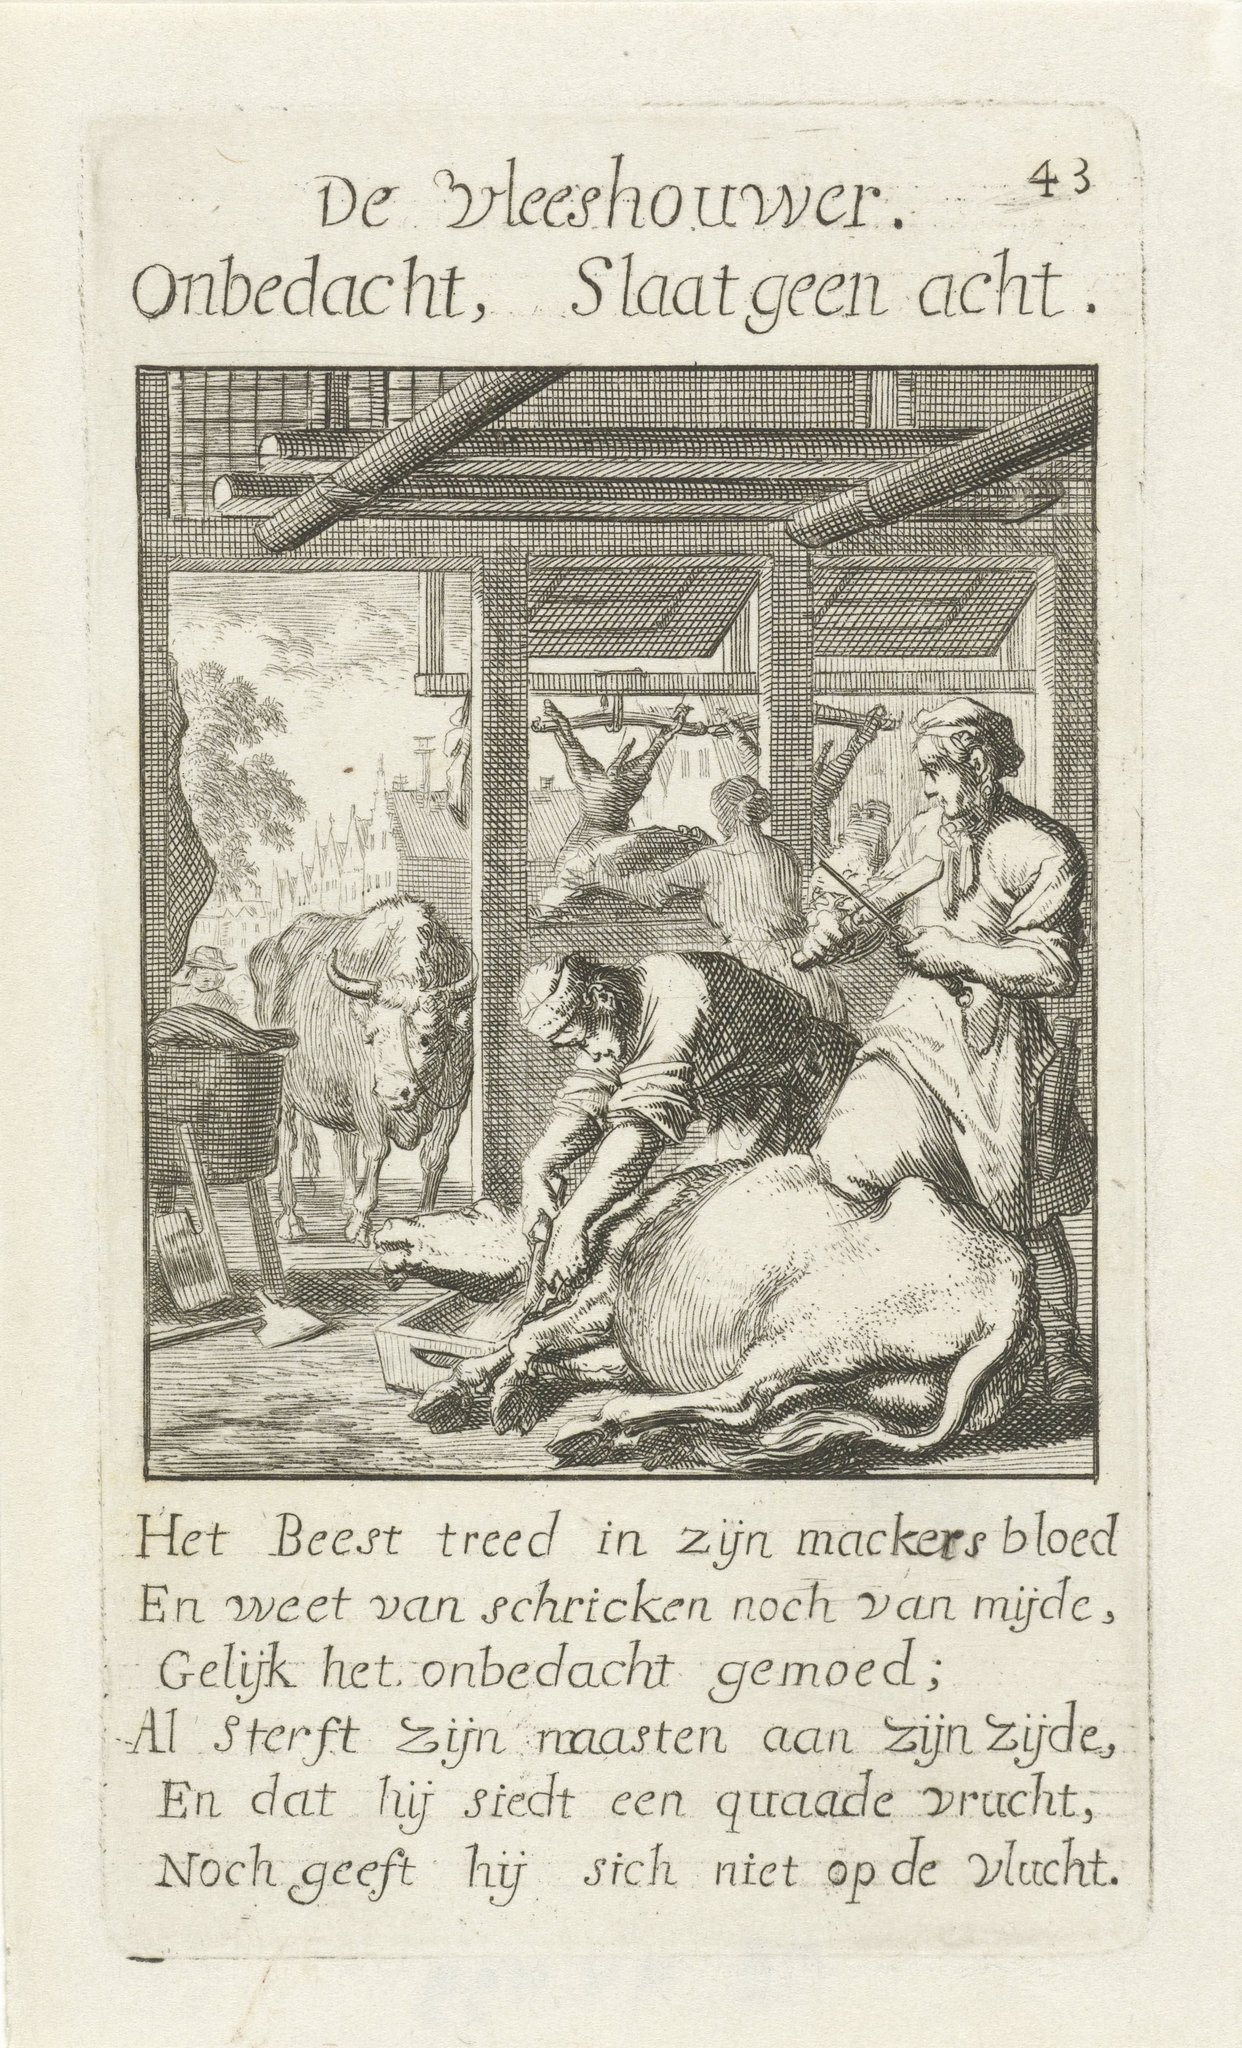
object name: print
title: Het Menselyk Bedryf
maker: jan luyken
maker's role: draughtsman, print maker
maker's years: 1649-1712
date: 1694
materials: paper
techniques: etching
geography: amsterdam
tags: handicrafts, craftsman at work, butcher, slaughterman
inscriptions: collector's mark: Lugt 2228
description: Maakt deel uit van de 100-delige serie beroepsprenten van Jan en Caspar Luyken, getiteld: Het menselyk bedryf. S.l.s.n., 1694 (eerste druk).